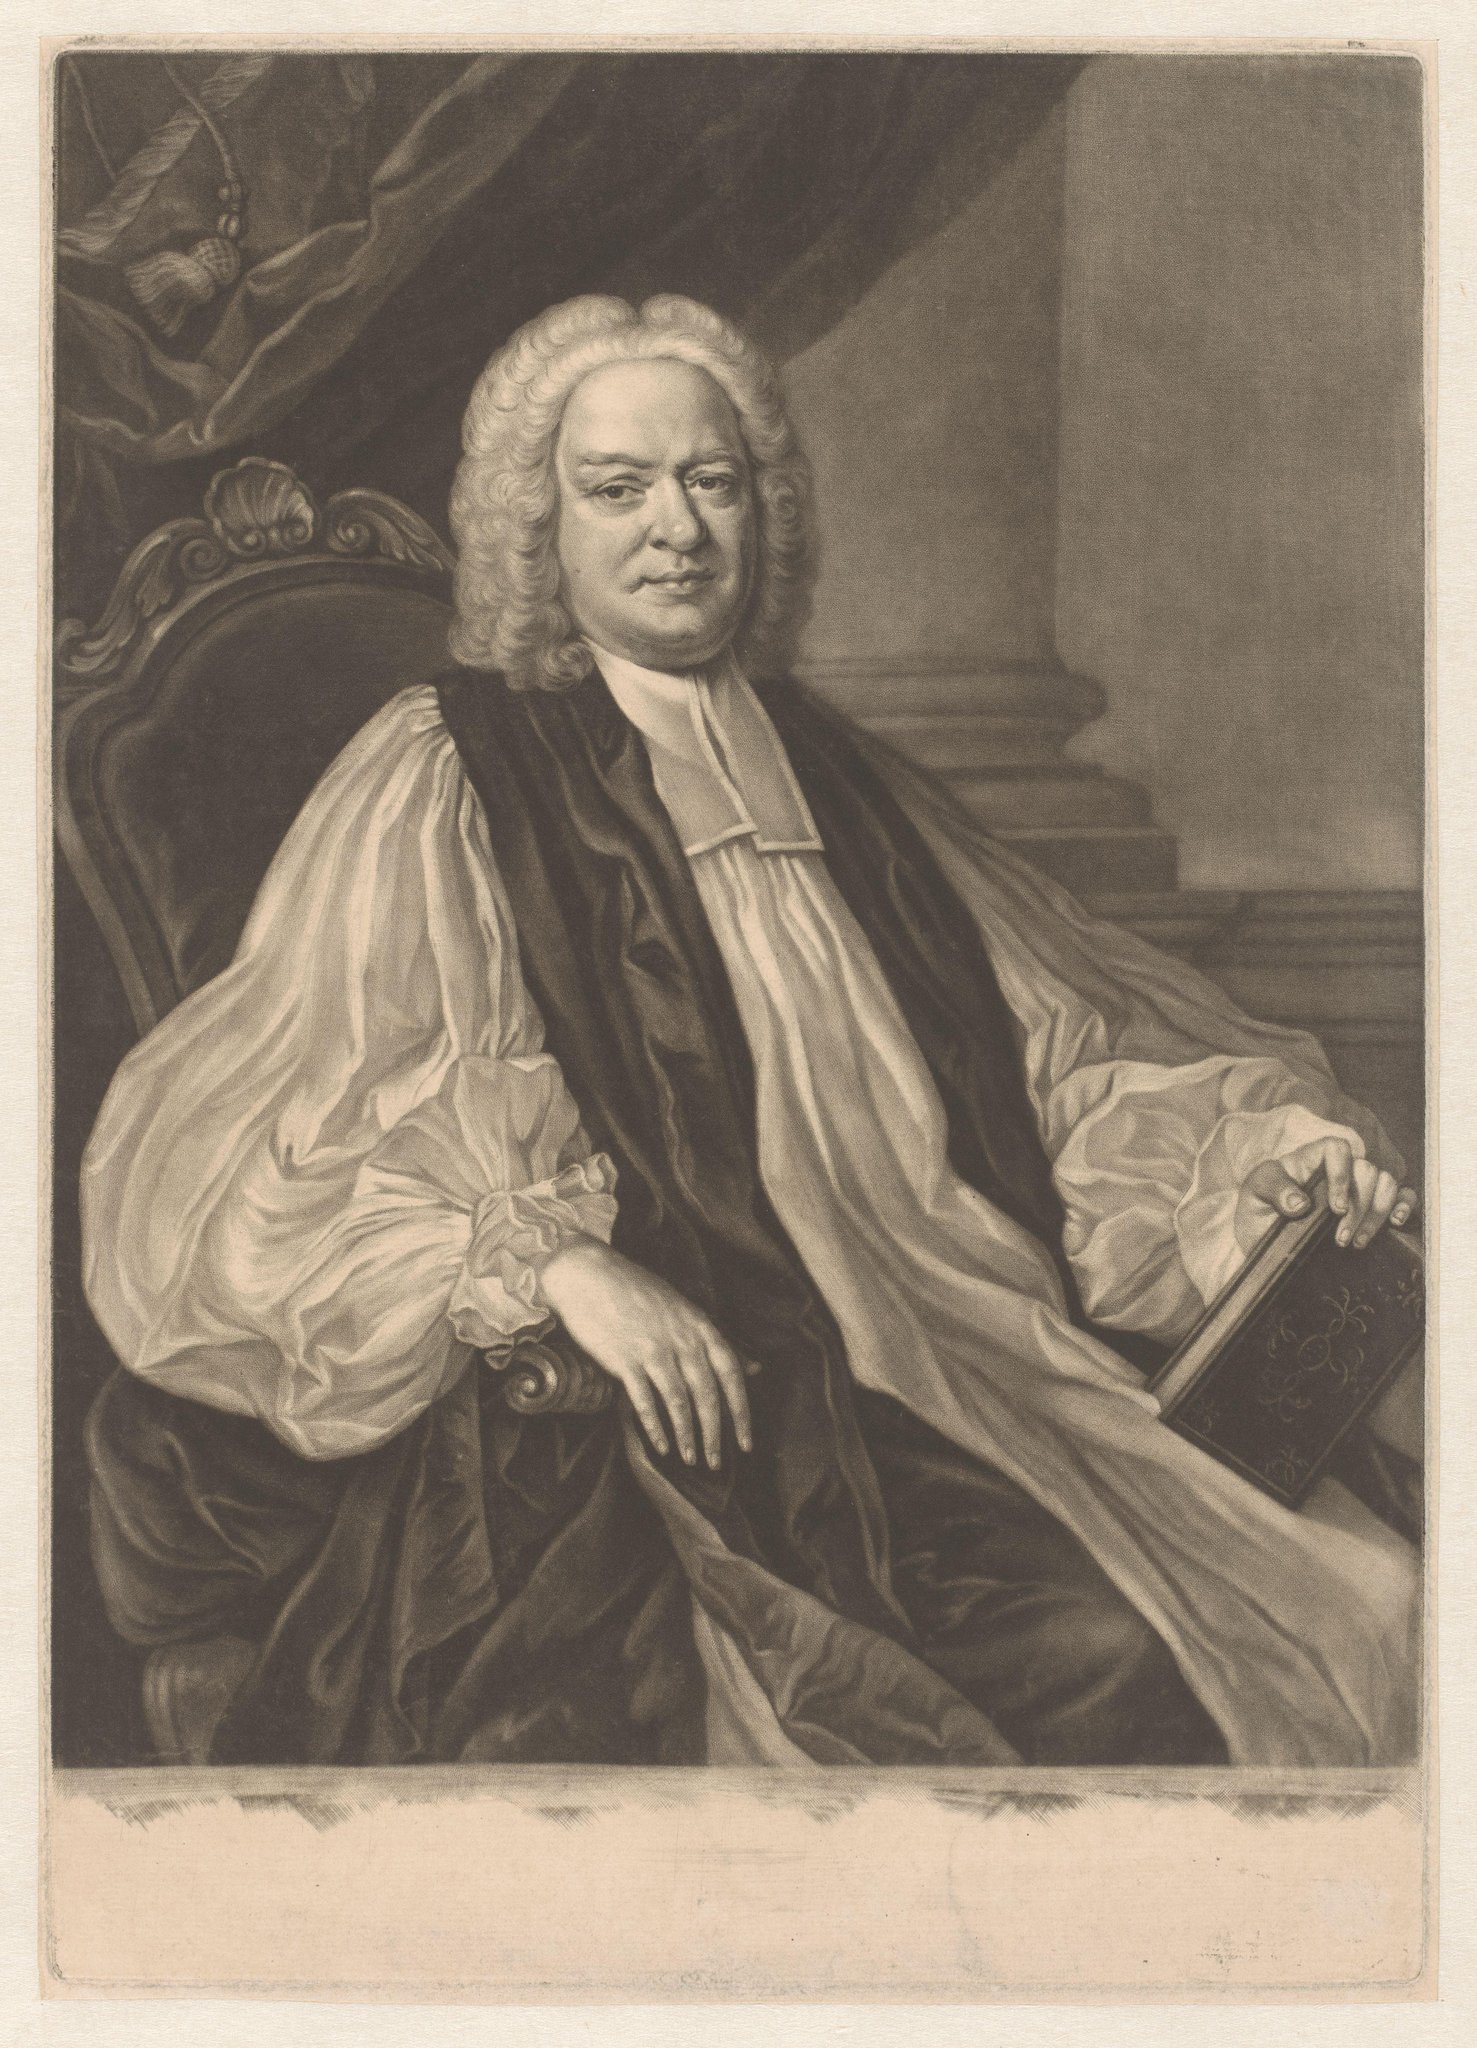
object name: print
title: Portret van Thomas Sherlock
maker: james mcardell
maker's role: print maker, publisher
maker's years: 1728-1765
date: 1757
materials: paper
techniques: mezzotint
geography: london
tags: clergyman, historical persons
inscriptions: collector's mark: Lugt 240